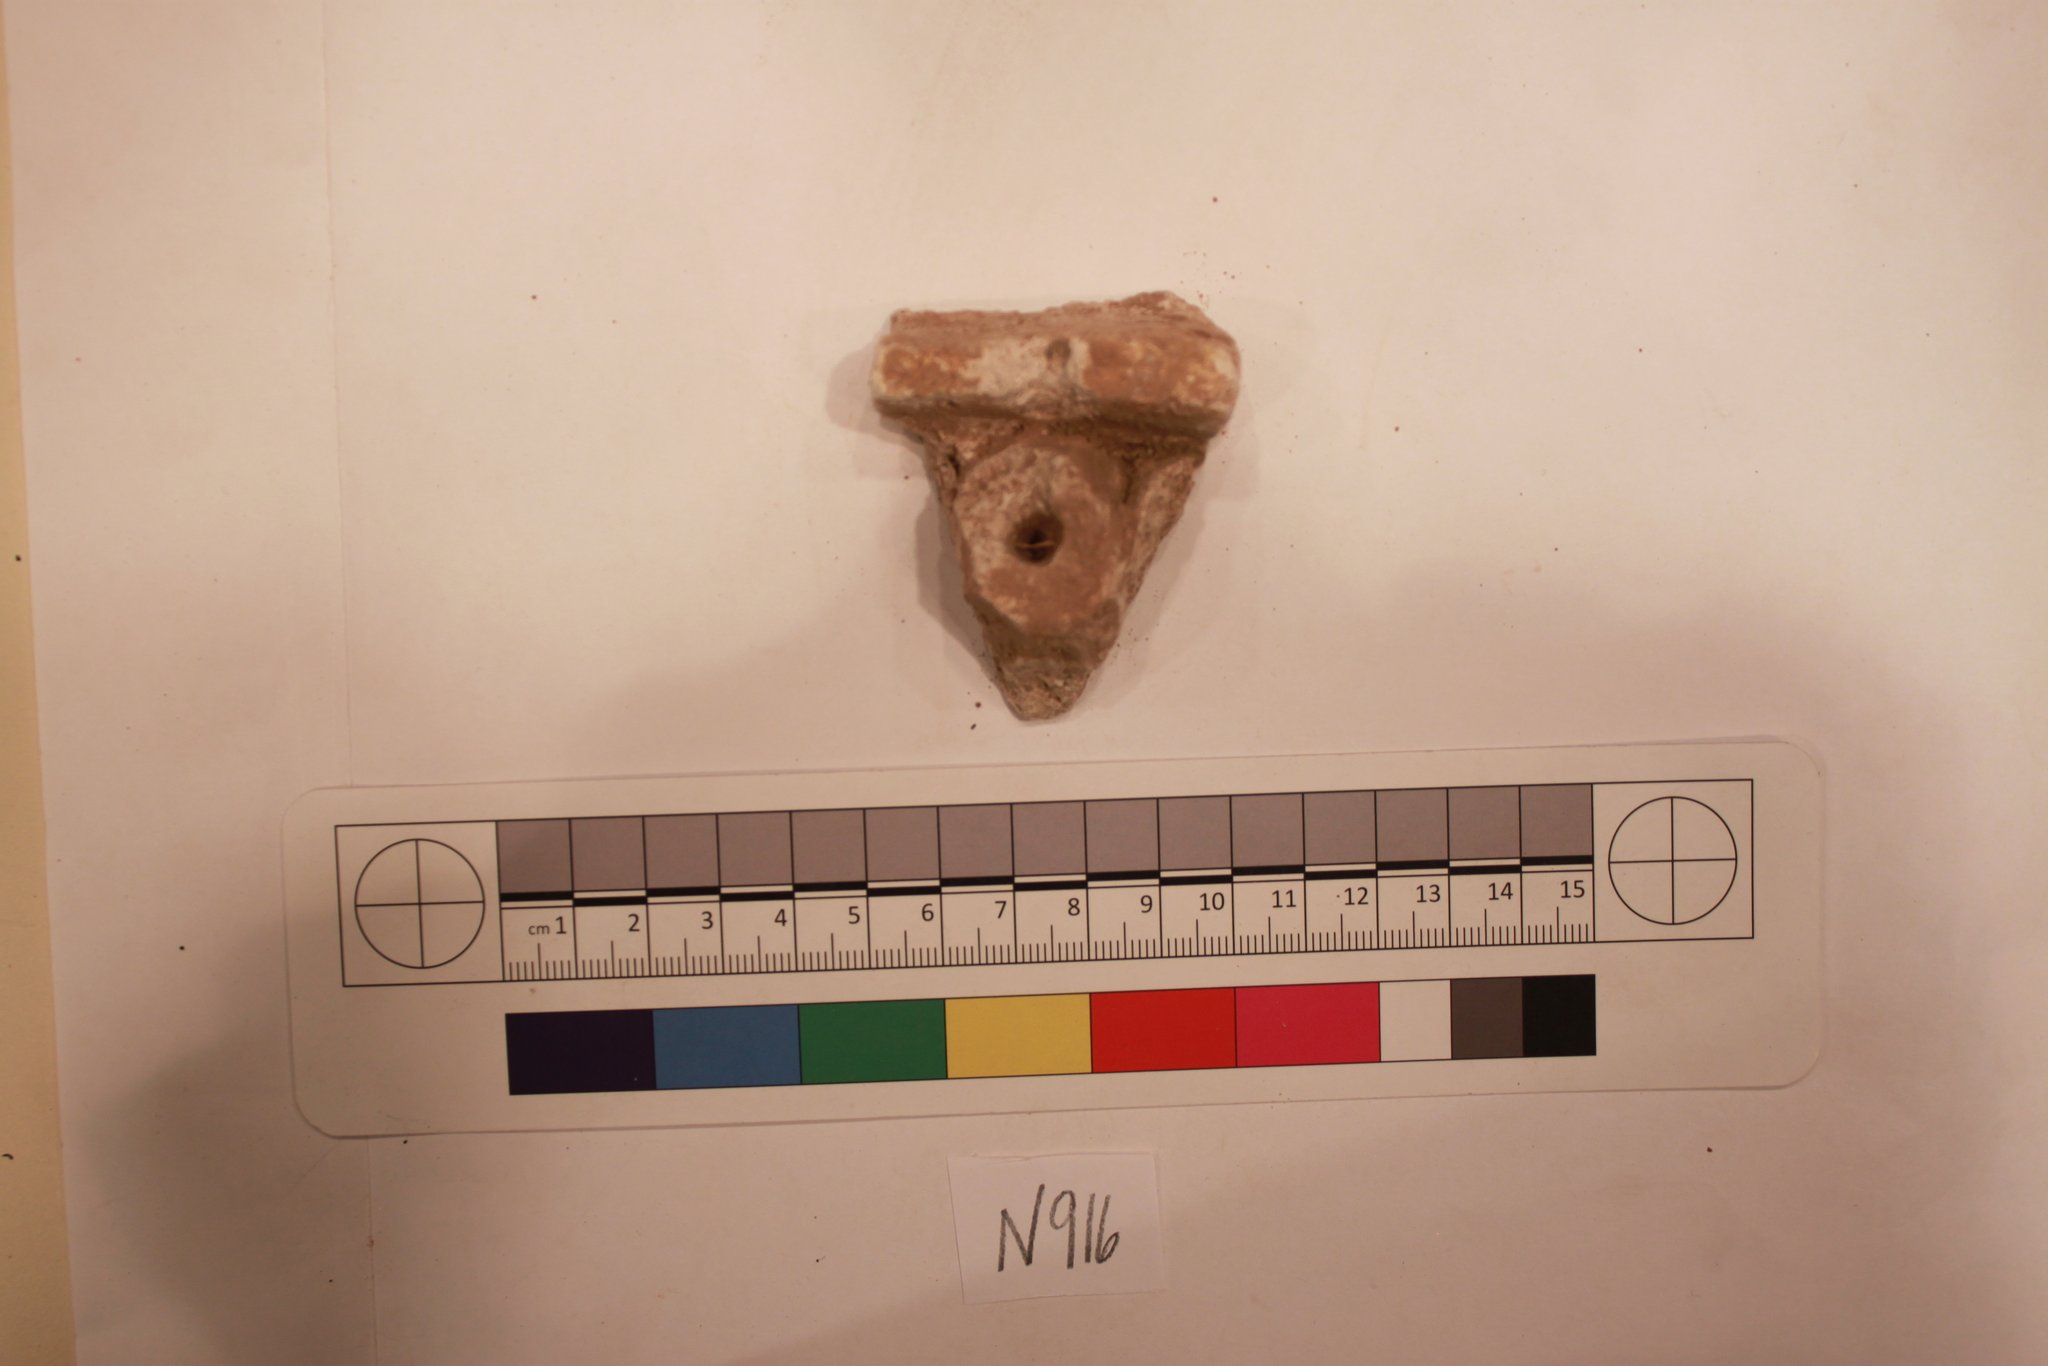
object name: fragment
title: Stucco Fragment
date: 701-1200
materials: plaster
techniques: carving, painting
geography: iran